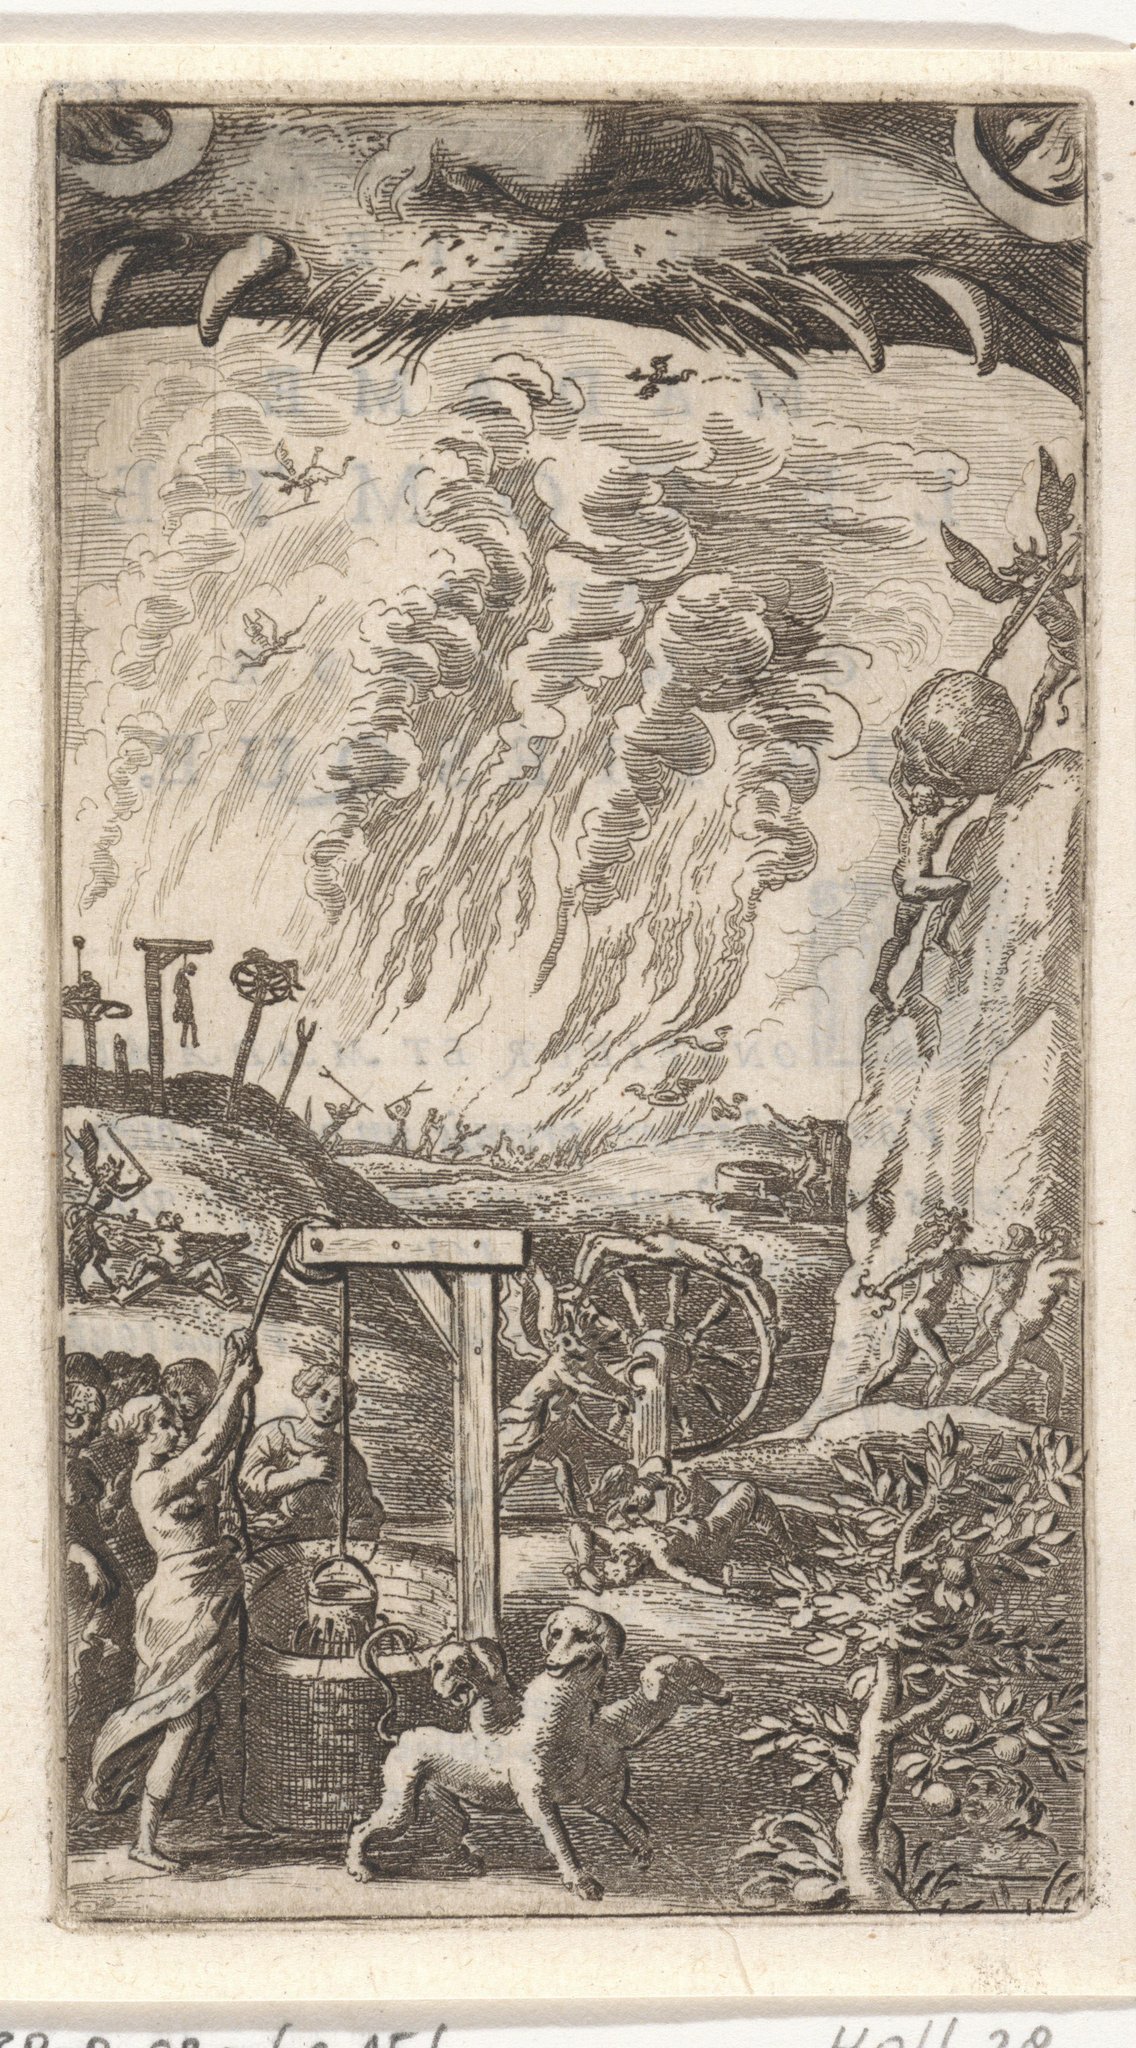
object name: book illustration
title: Tartarus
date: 1668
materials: paper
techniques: etching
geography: netherlands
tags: other sufferers in tartarus, the danaids pouring water into a perforated vessel, tantalus, suffering eternal hunger and thirst, ixion on a burning wheel, sisyphus pushing his boulder uphill or carrying it on his shoulders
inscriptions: collector's mark: Lugt 2228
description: Linksvoor halen de Danaïden met een emmer vol gaten water uit een put. Daarvoor staat Cerberus. Rechtsvoor Tantalus onder takken met fruit. In het midden wordt Ixion door een gevleugeld wezen op een rad gebonden. Daarachter een persoon aan een galg, geradbraakte figuren en een man op een X-vormig kruis, die door een gevleugeld wezen wordt geslagen. Voor het rad ligt Tityus op de grond, terwijl een gier zijn hart en lever pikt. Rechts wordt de kei van Sisyphus vanaf een rotswand naar beneden geduwd. Daaronder worden twee naakte vrouwen weggevoerd. Boven de geopende muil van Leviatan. Verso een tekstblad met de opdracht.